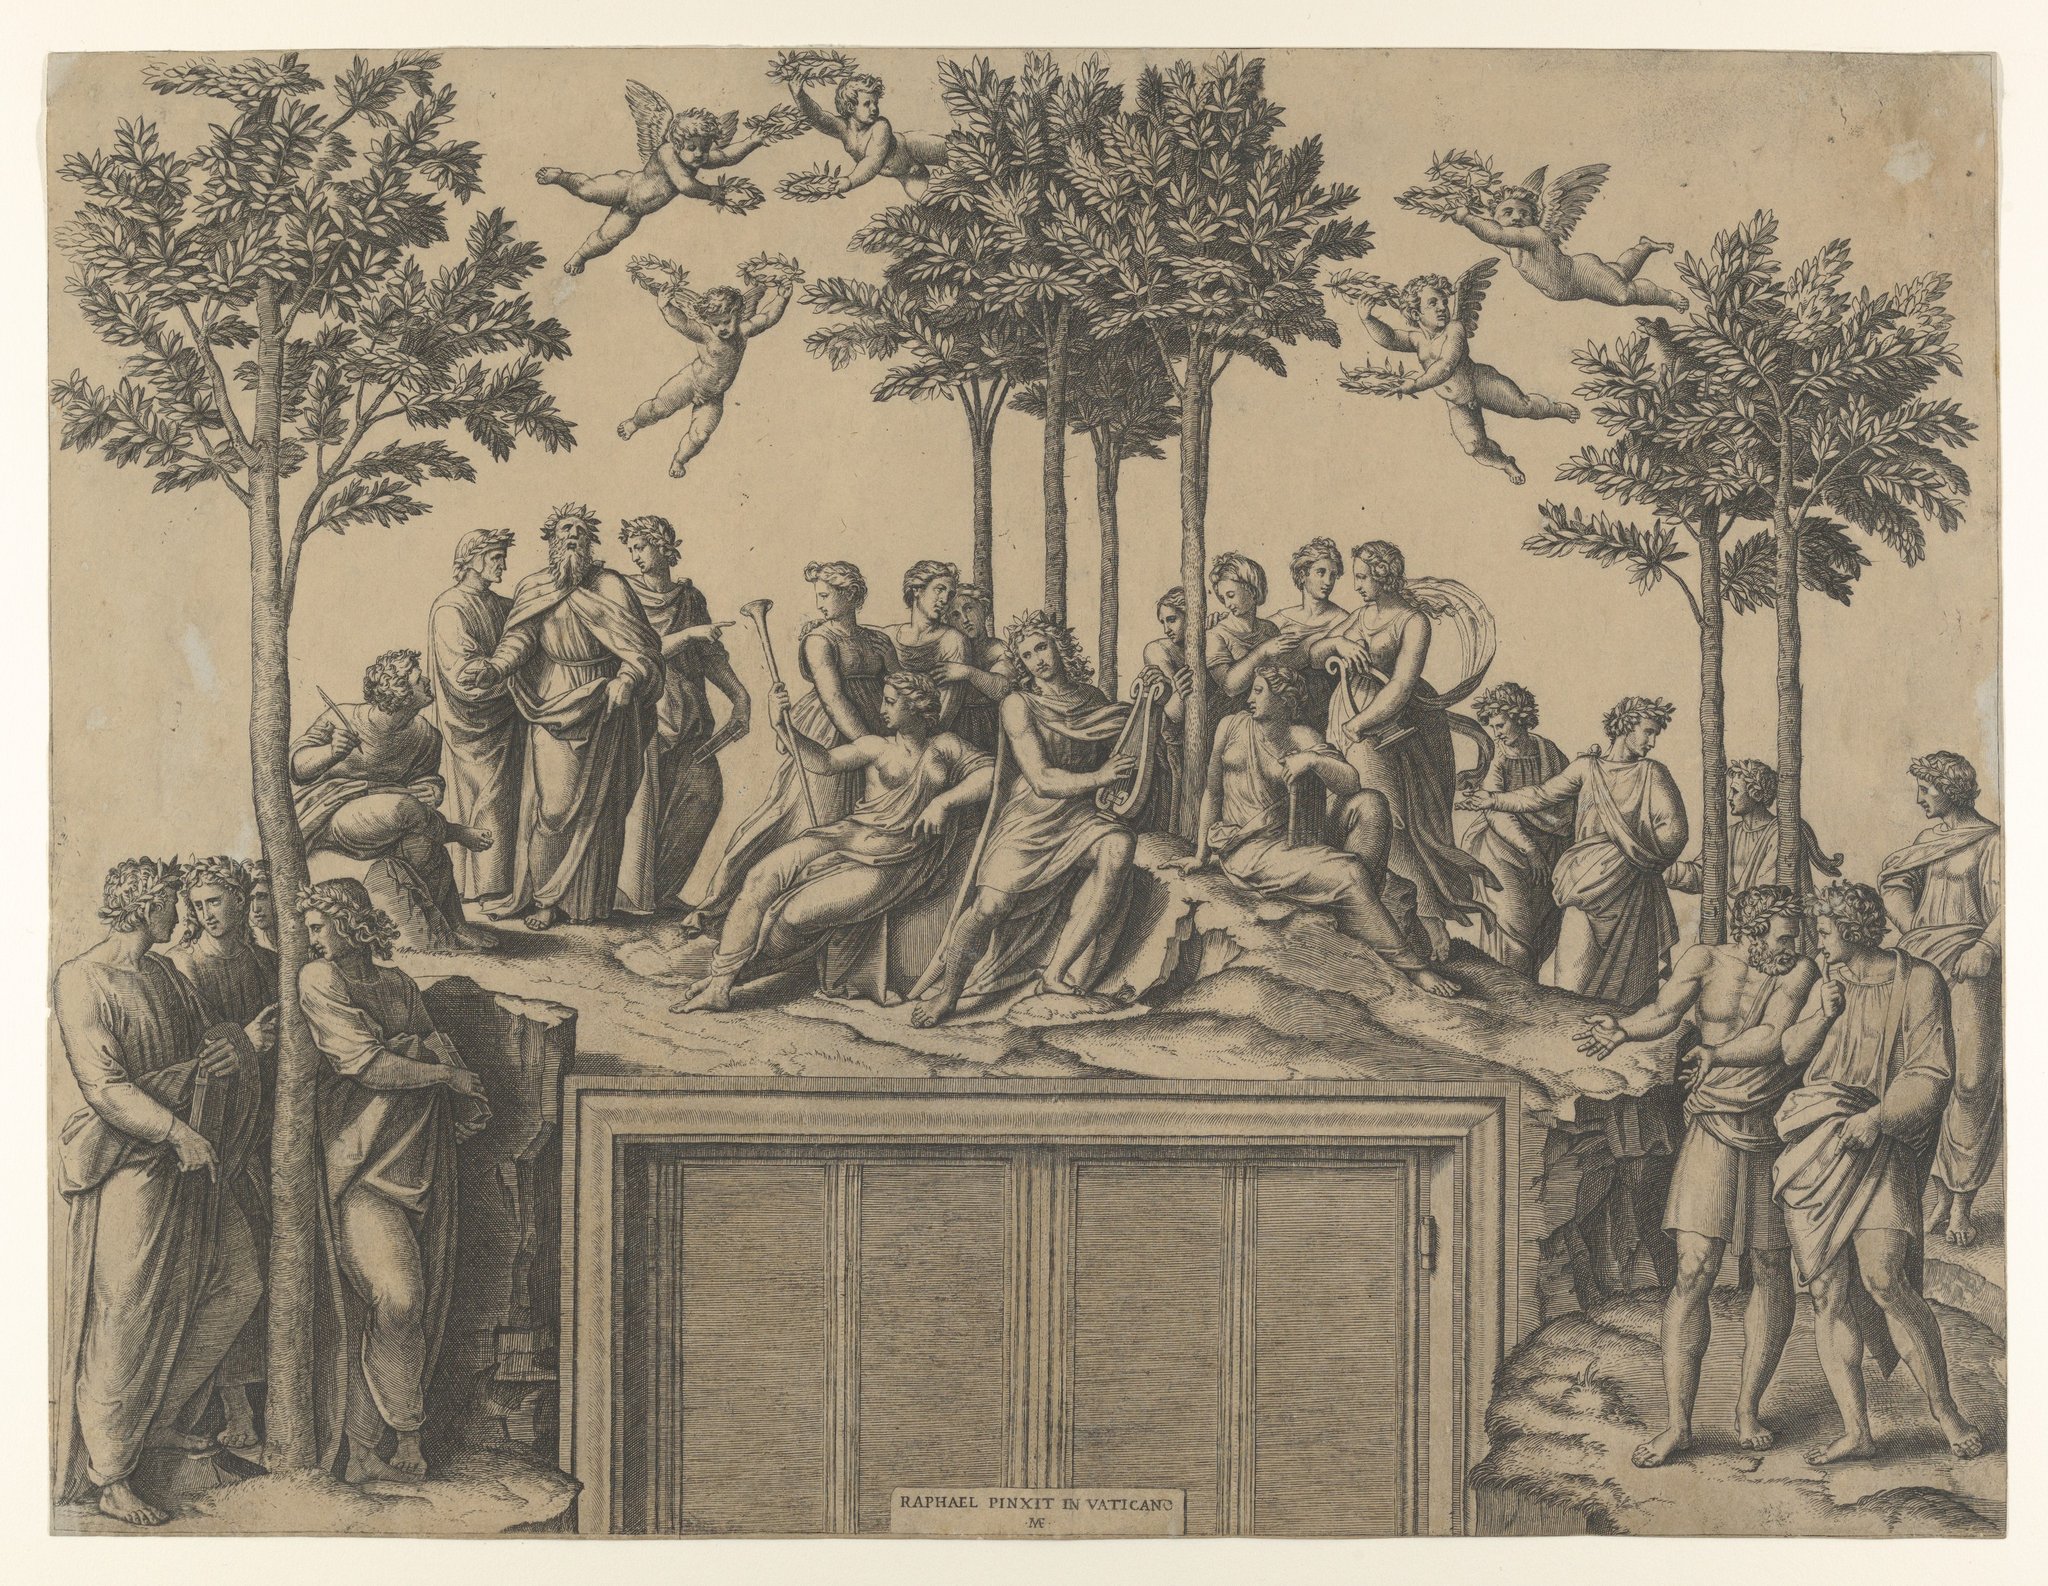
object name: print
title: Apollo sitting on Parnassus surrounded by the muses and famous poets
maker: marcantonio raimondi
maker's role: artist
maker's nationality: italian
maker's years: 1475-1534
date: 1517-1520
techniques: engraving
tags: human figures,apollo,putti,muses